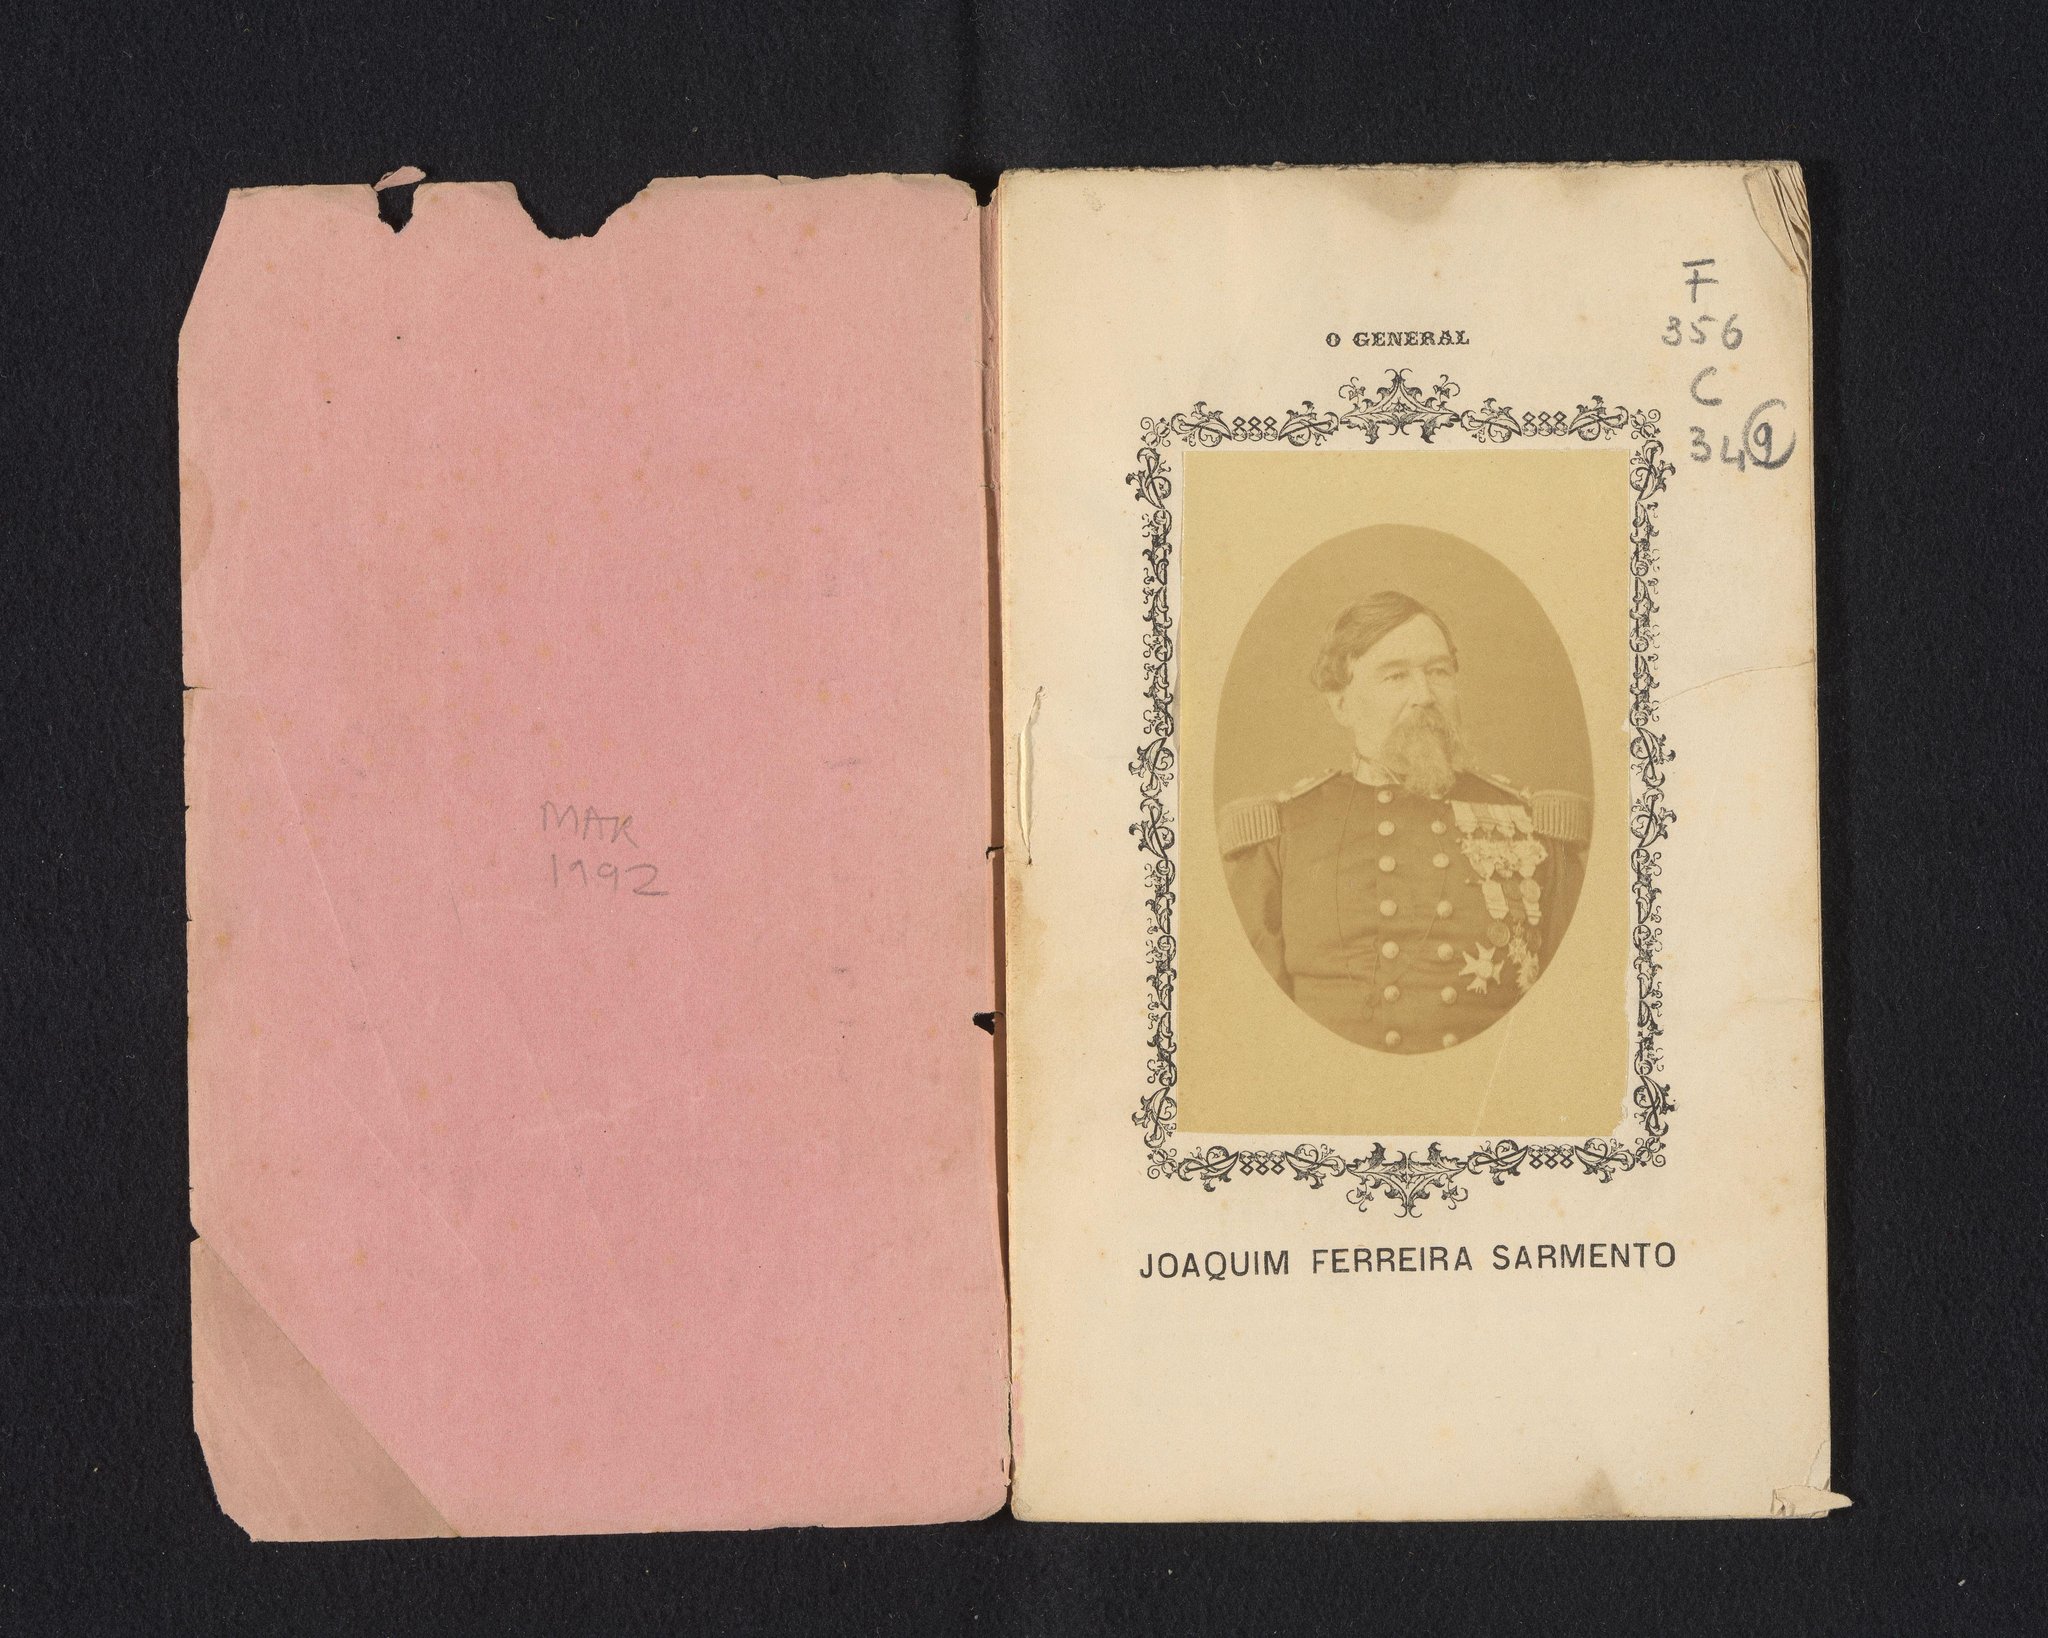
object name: page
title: Portret van generaal Joaquim Ferreira Sarmanto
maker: Anonymous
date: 1873-1878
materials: paper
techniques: albumen print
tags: historical persons